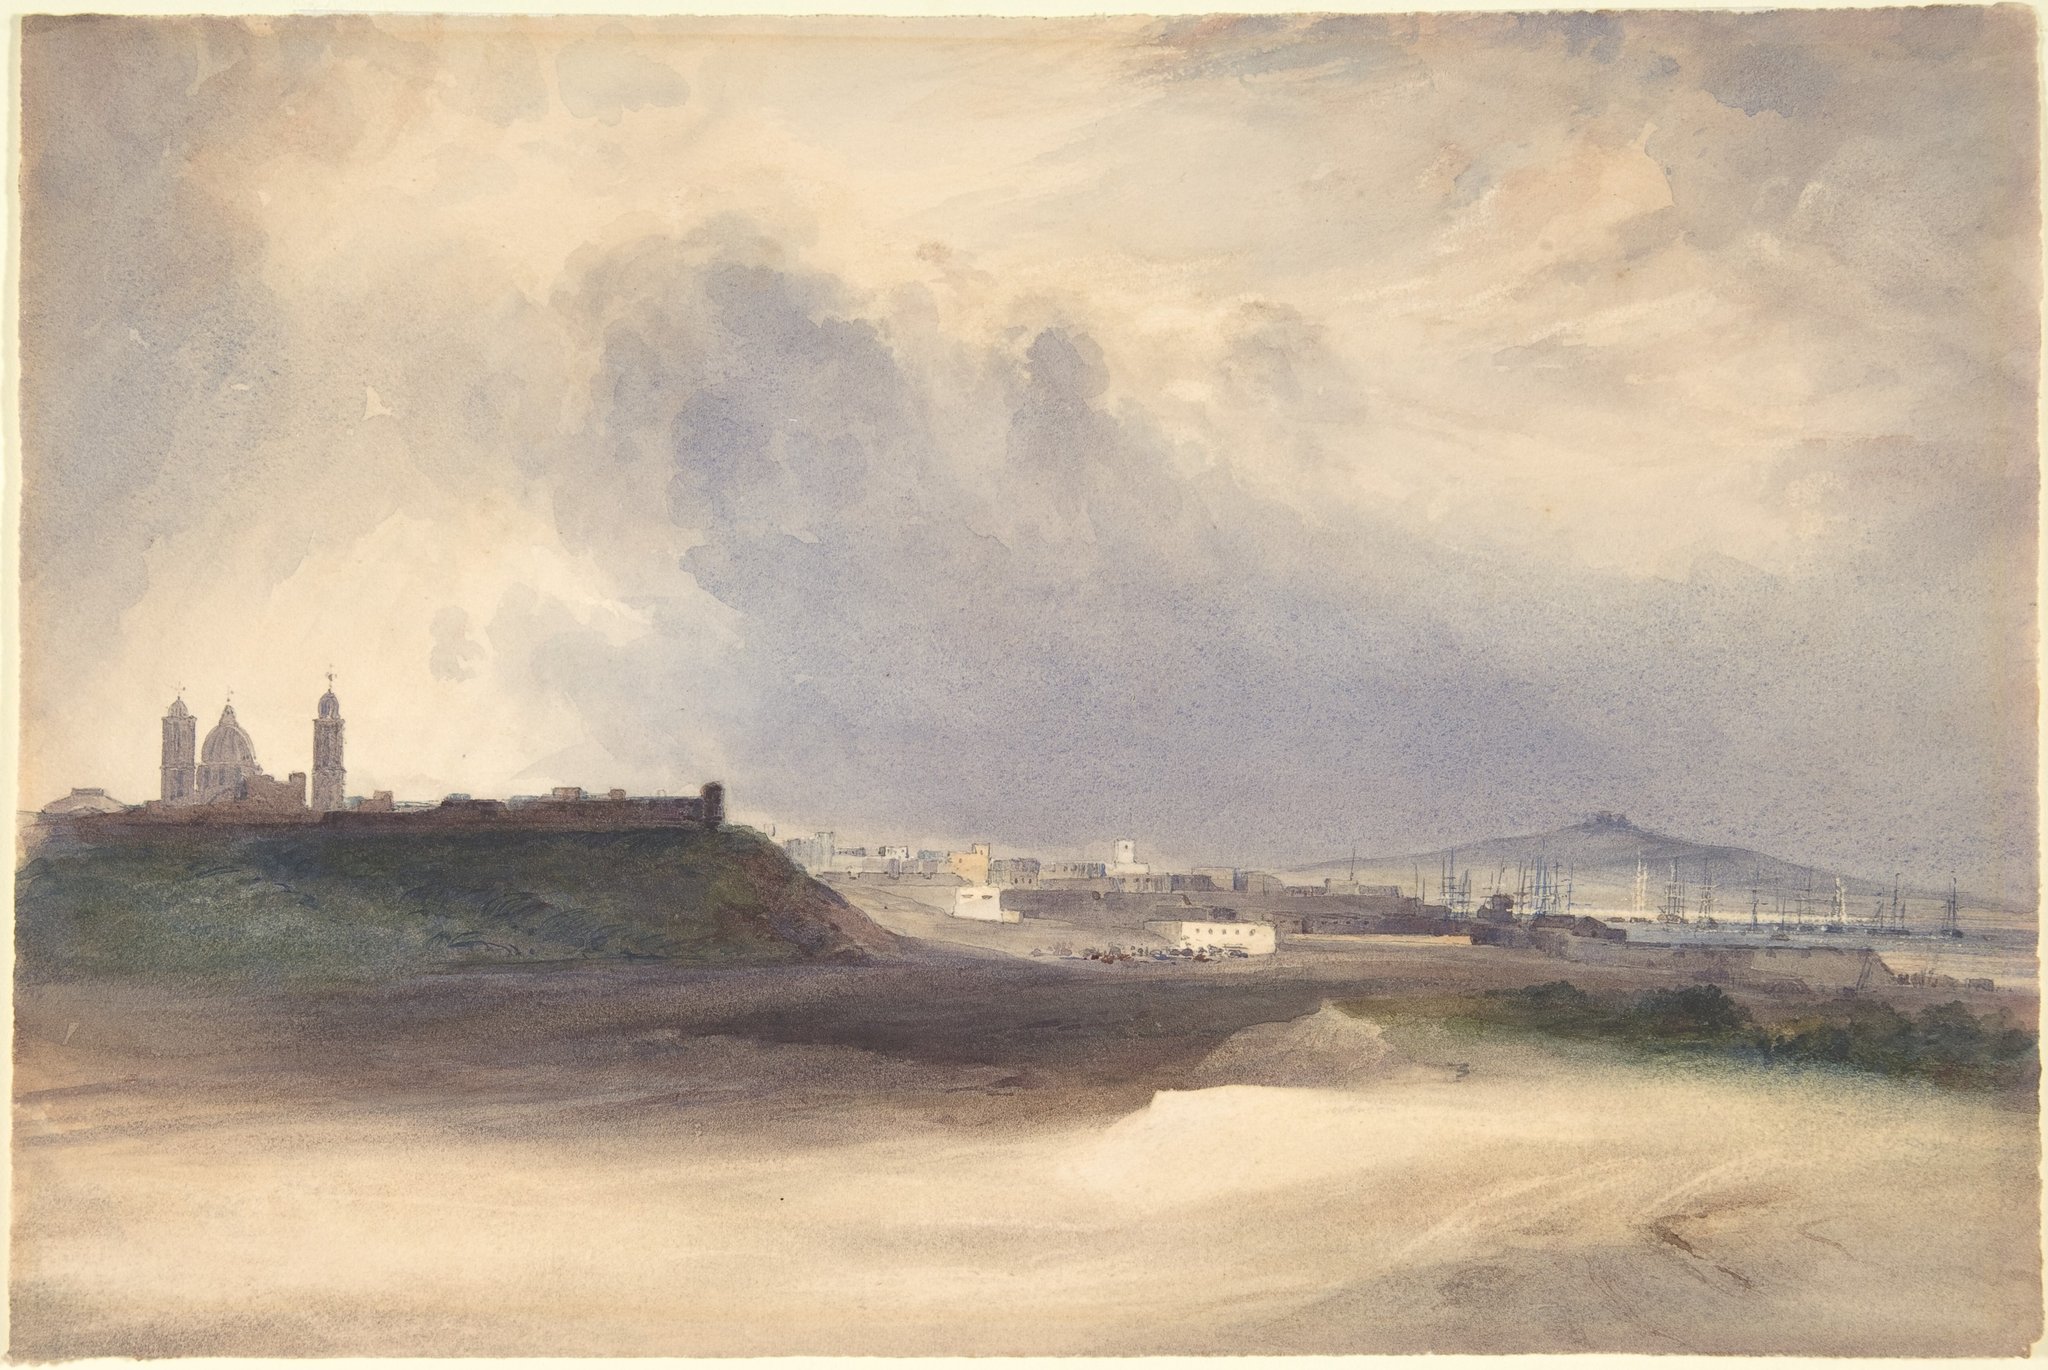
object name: drawing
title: Approach to Montevideo, Uruguay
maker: conrad martens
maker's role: artist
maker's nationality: british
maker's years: 1801-1878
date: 1832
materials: graphite, watercolor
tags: buildings,churches,landscapes